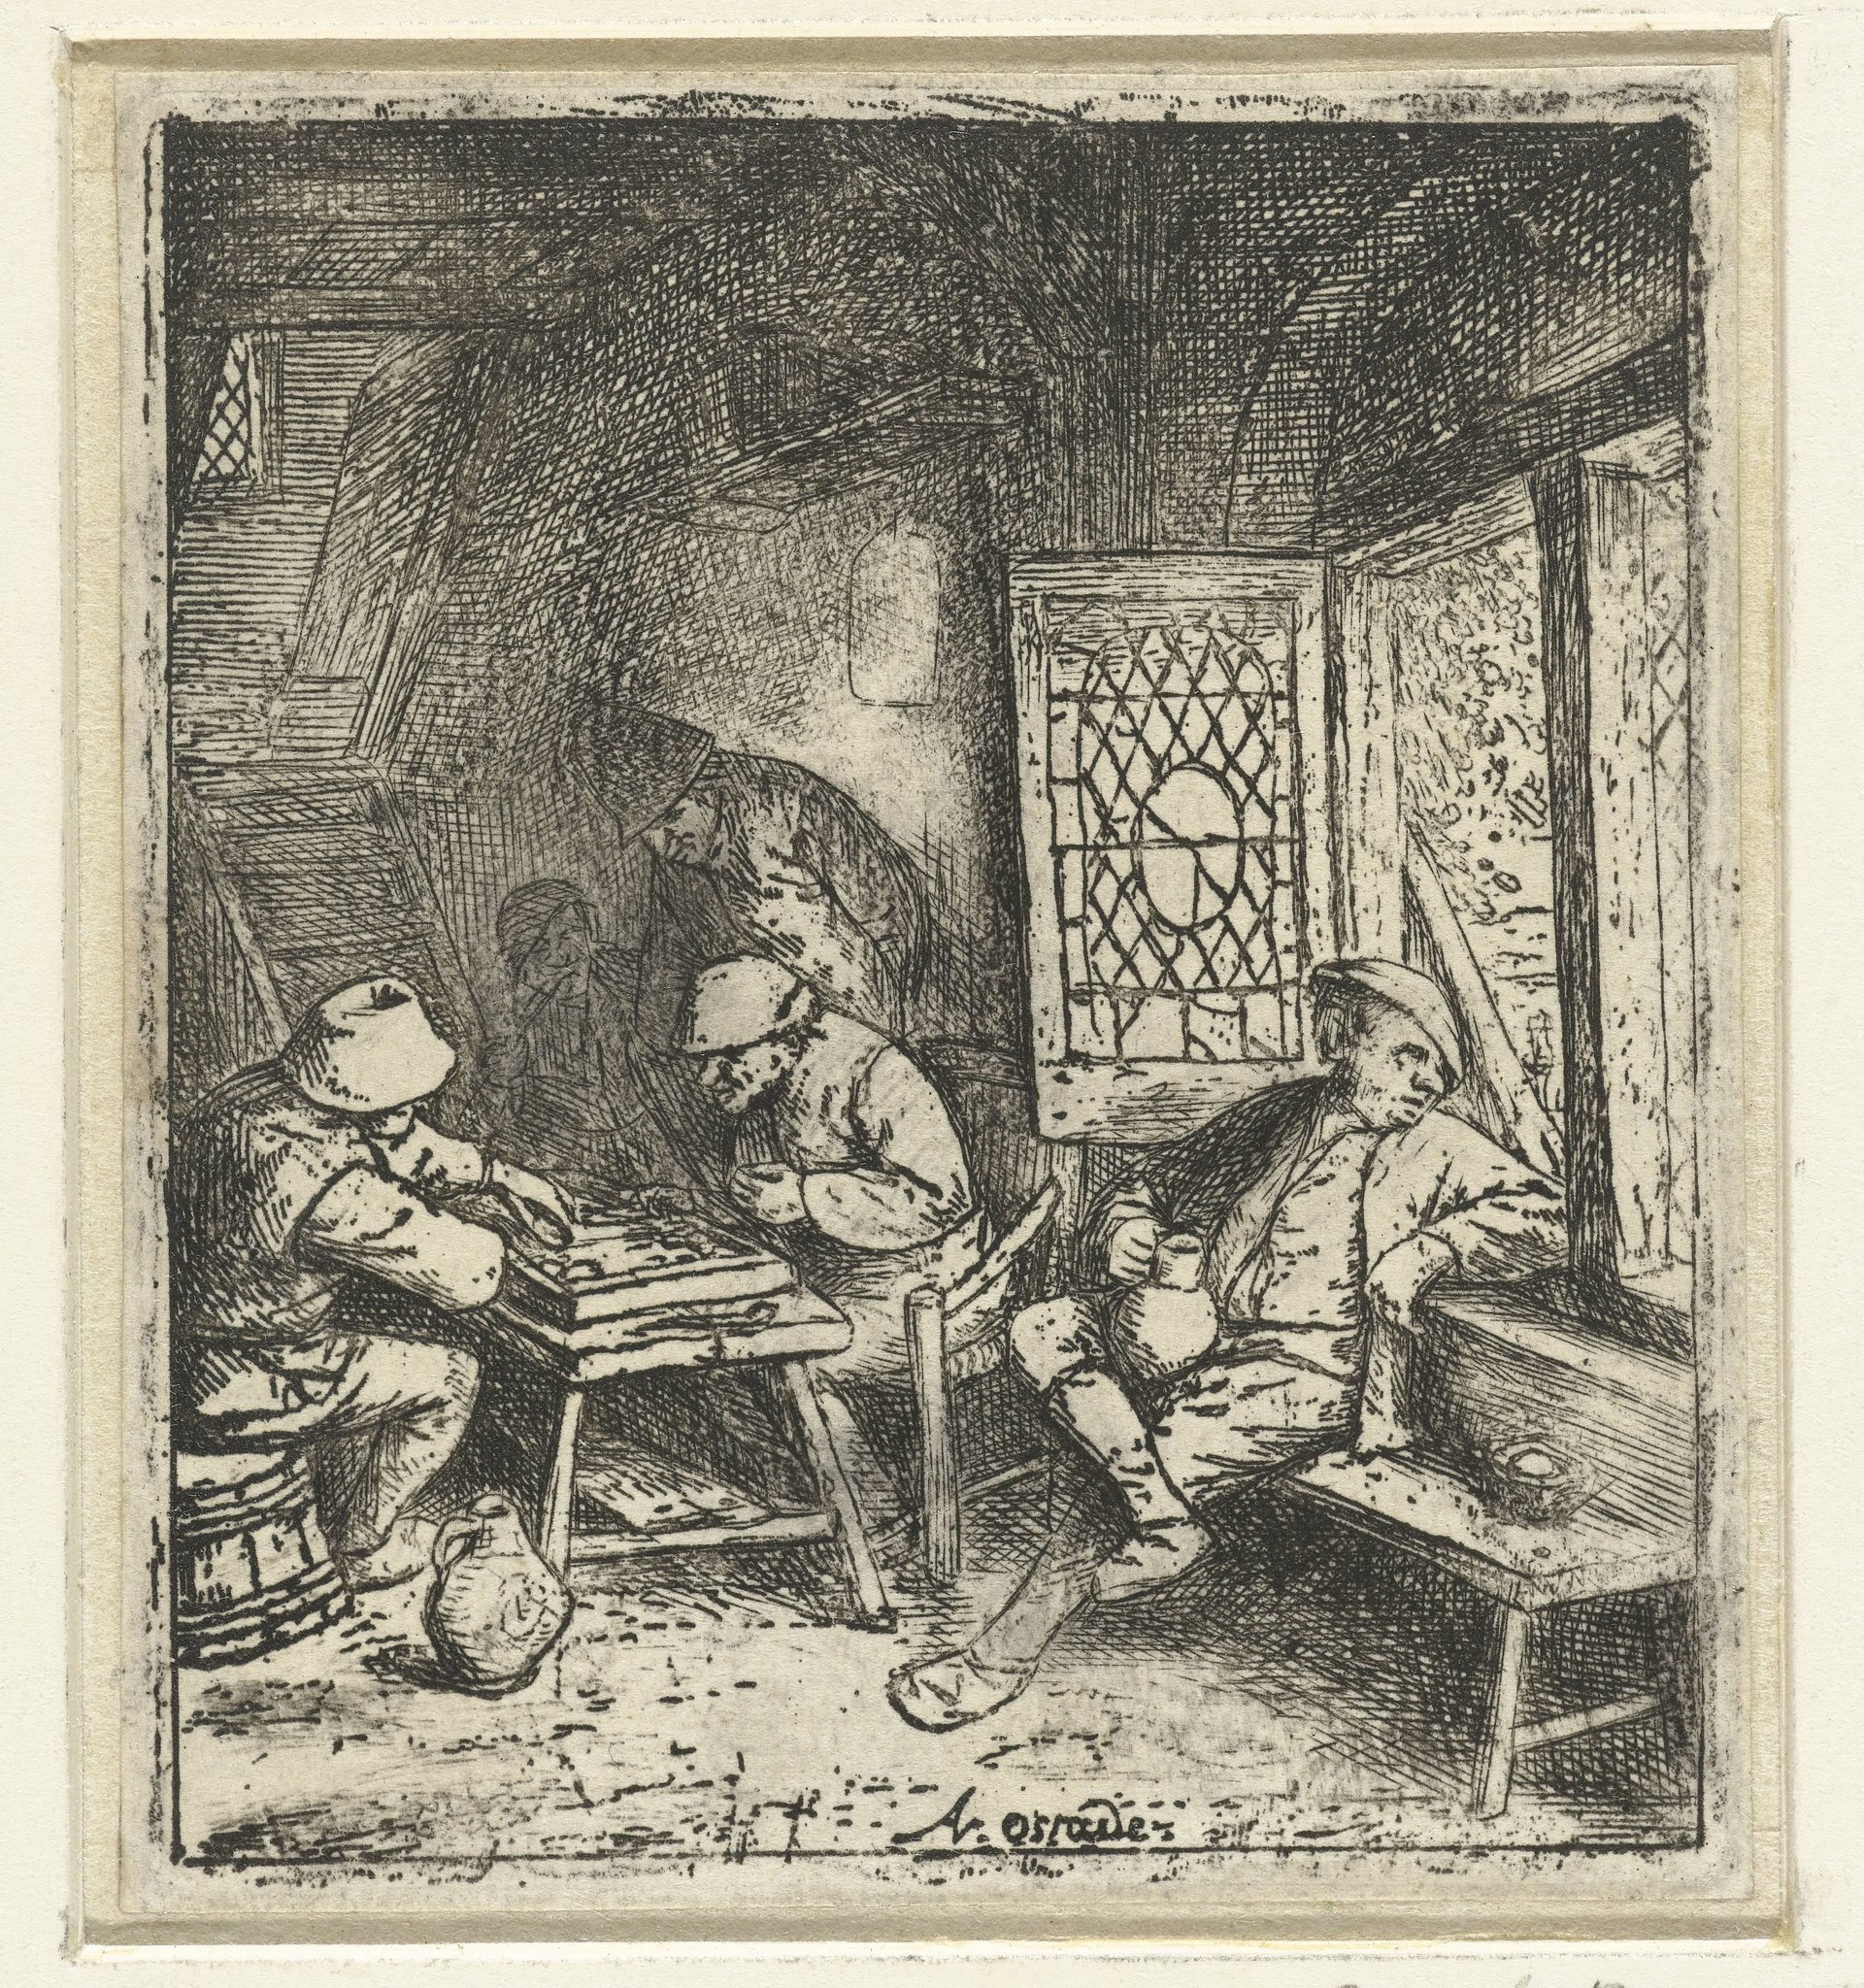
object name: print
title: Trictrac spelers in een herberg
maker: adriaen van ostade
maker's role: draughtsman, painter, print maker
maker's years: 1610-1685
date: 1666-1670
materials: paper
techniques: etching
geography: haarlem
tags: inn, coffee-house, public house, etc., backgammon, tric-trac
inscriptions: collector's mark: Lugt 2233